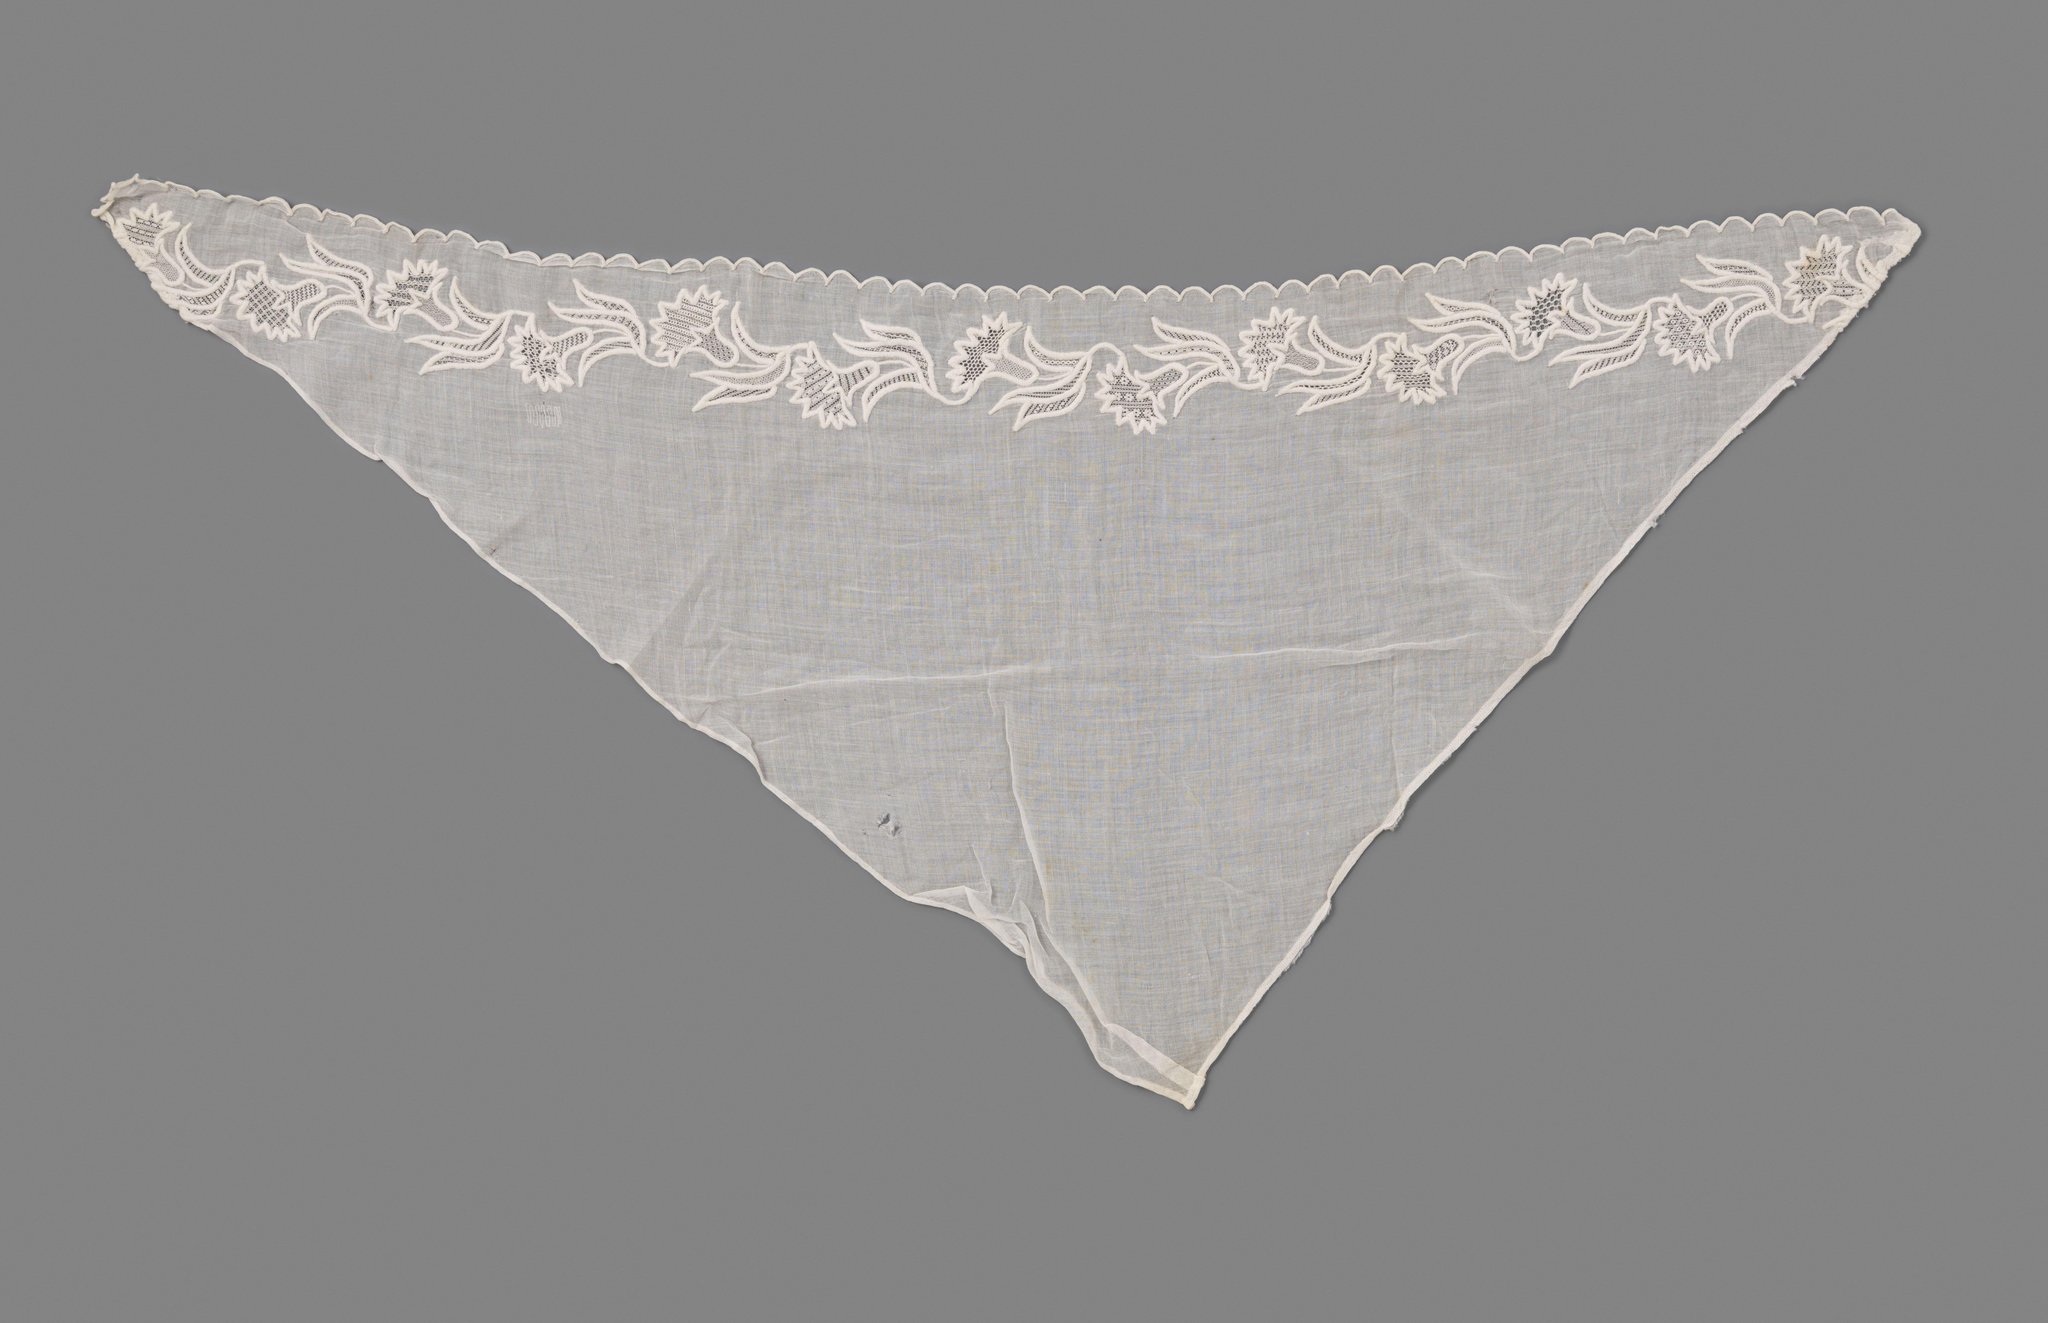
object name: womenswear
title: Fichu van linnenbatist, driehoekig en geschulpt, geborduurd met een rand van anjers in naaldkantsteken en festonwerk (plumétis) van wit katoen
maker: Anonymous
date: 1800-1820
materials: cotton, linen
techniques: embroidered, weave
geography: netherlands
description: Fichu van linnenbatist, driehoekig en geschulpt, geborduurd met een rand anjers in naaldkantsteken en festonwerk (plumétis) van wit katoen. Waarschijnlijk is de fichu oorspronkelijk groter geweest.